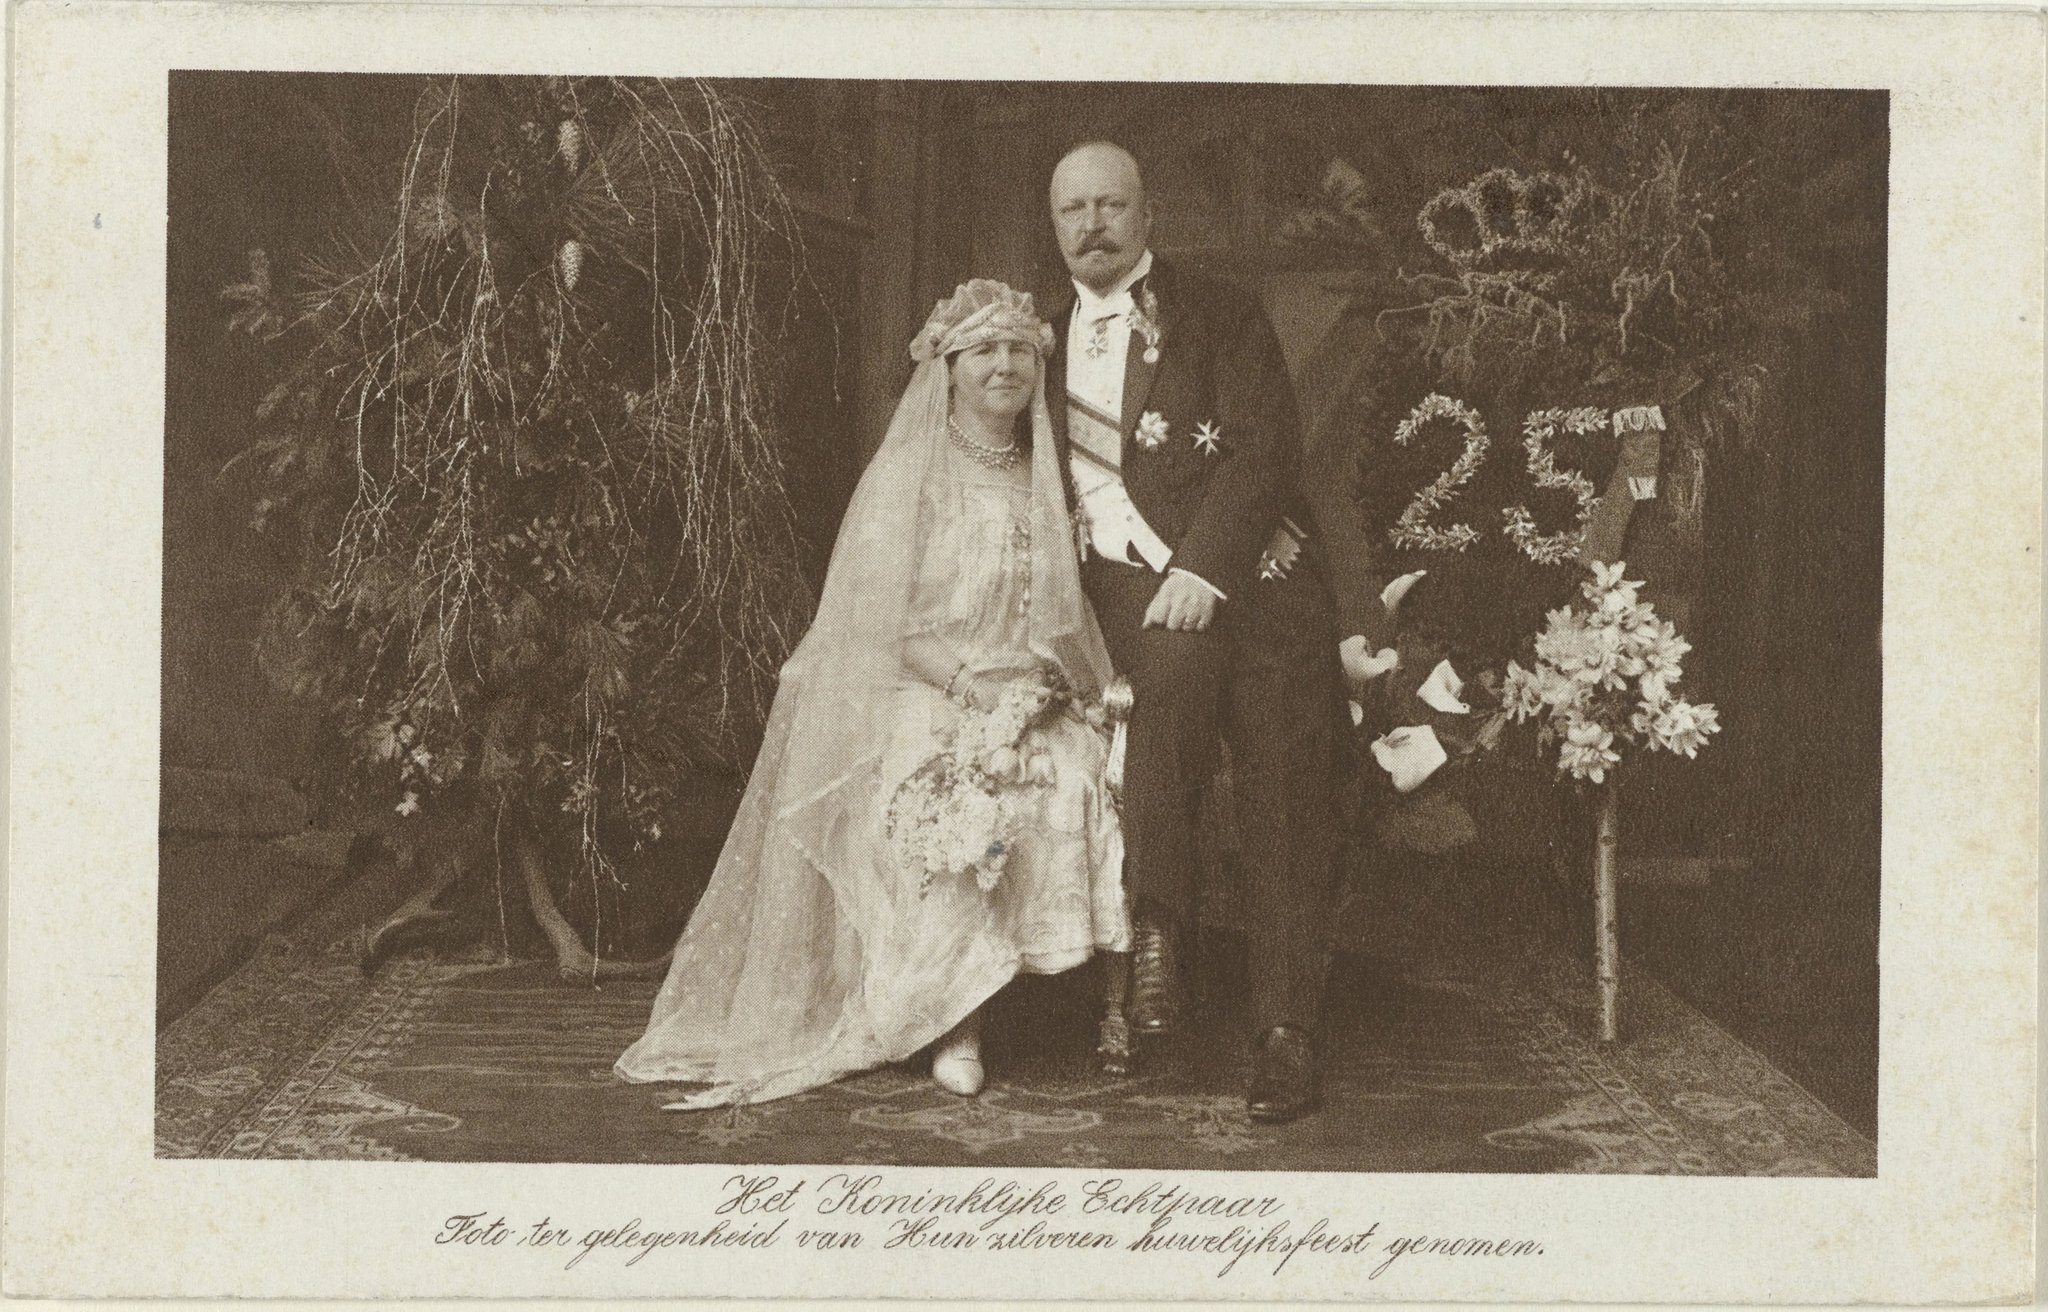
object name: ansichtkaart, prentbriefkaart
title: Portret van Wilhelmina, koningin der Nederlanden, en Hendrik van Mecklenburg-Schwerin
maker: Anonymous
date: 1926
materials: paper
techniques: rotogravure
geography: leiden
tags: the hague, print maker, wilhelmina of the netherlands, hendrik (prins der nederlanden (1876-1934))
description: Portret van Wilhelmina en Hendrik. Rechts het getal '25'. In de ondermarge twee regels Nederlandse tekst. Vervaardigd ter gelegenheid van het 25-jarig huwelijksjubileum van Wilhelmina en Hendrik in 1926.